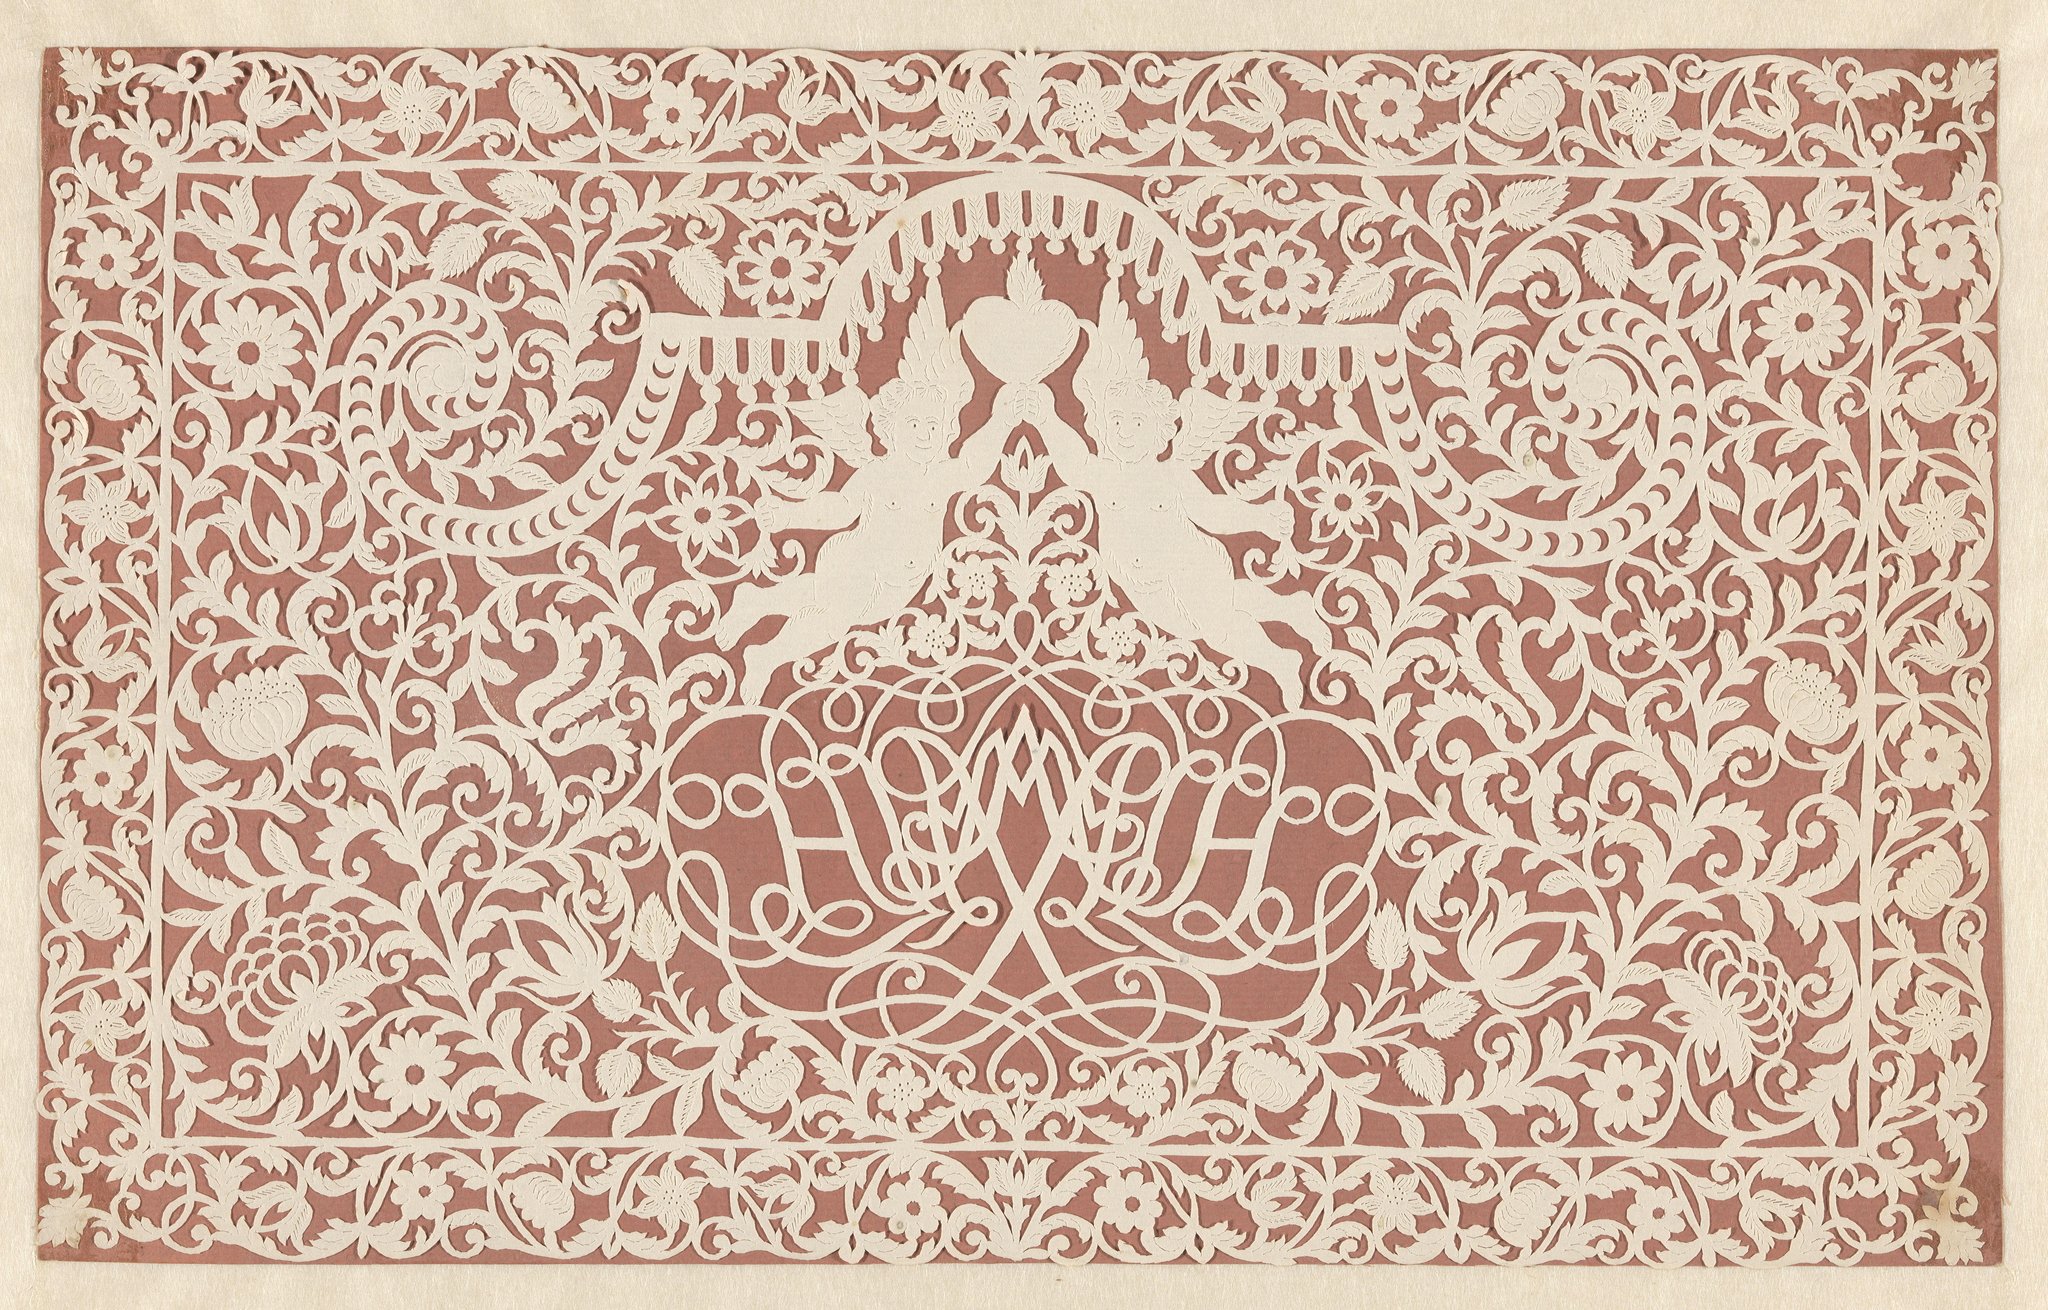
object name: cut paper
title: Huwelijksknipsel voor echtpaar Laars-Hooft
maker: Anonymous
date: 1749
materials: paper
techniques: cutting, snipping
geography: netherlands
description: Huwelijksknipsel voor echtpaar Laars-Hooft. Ornament met spiegelmonogram en putti.